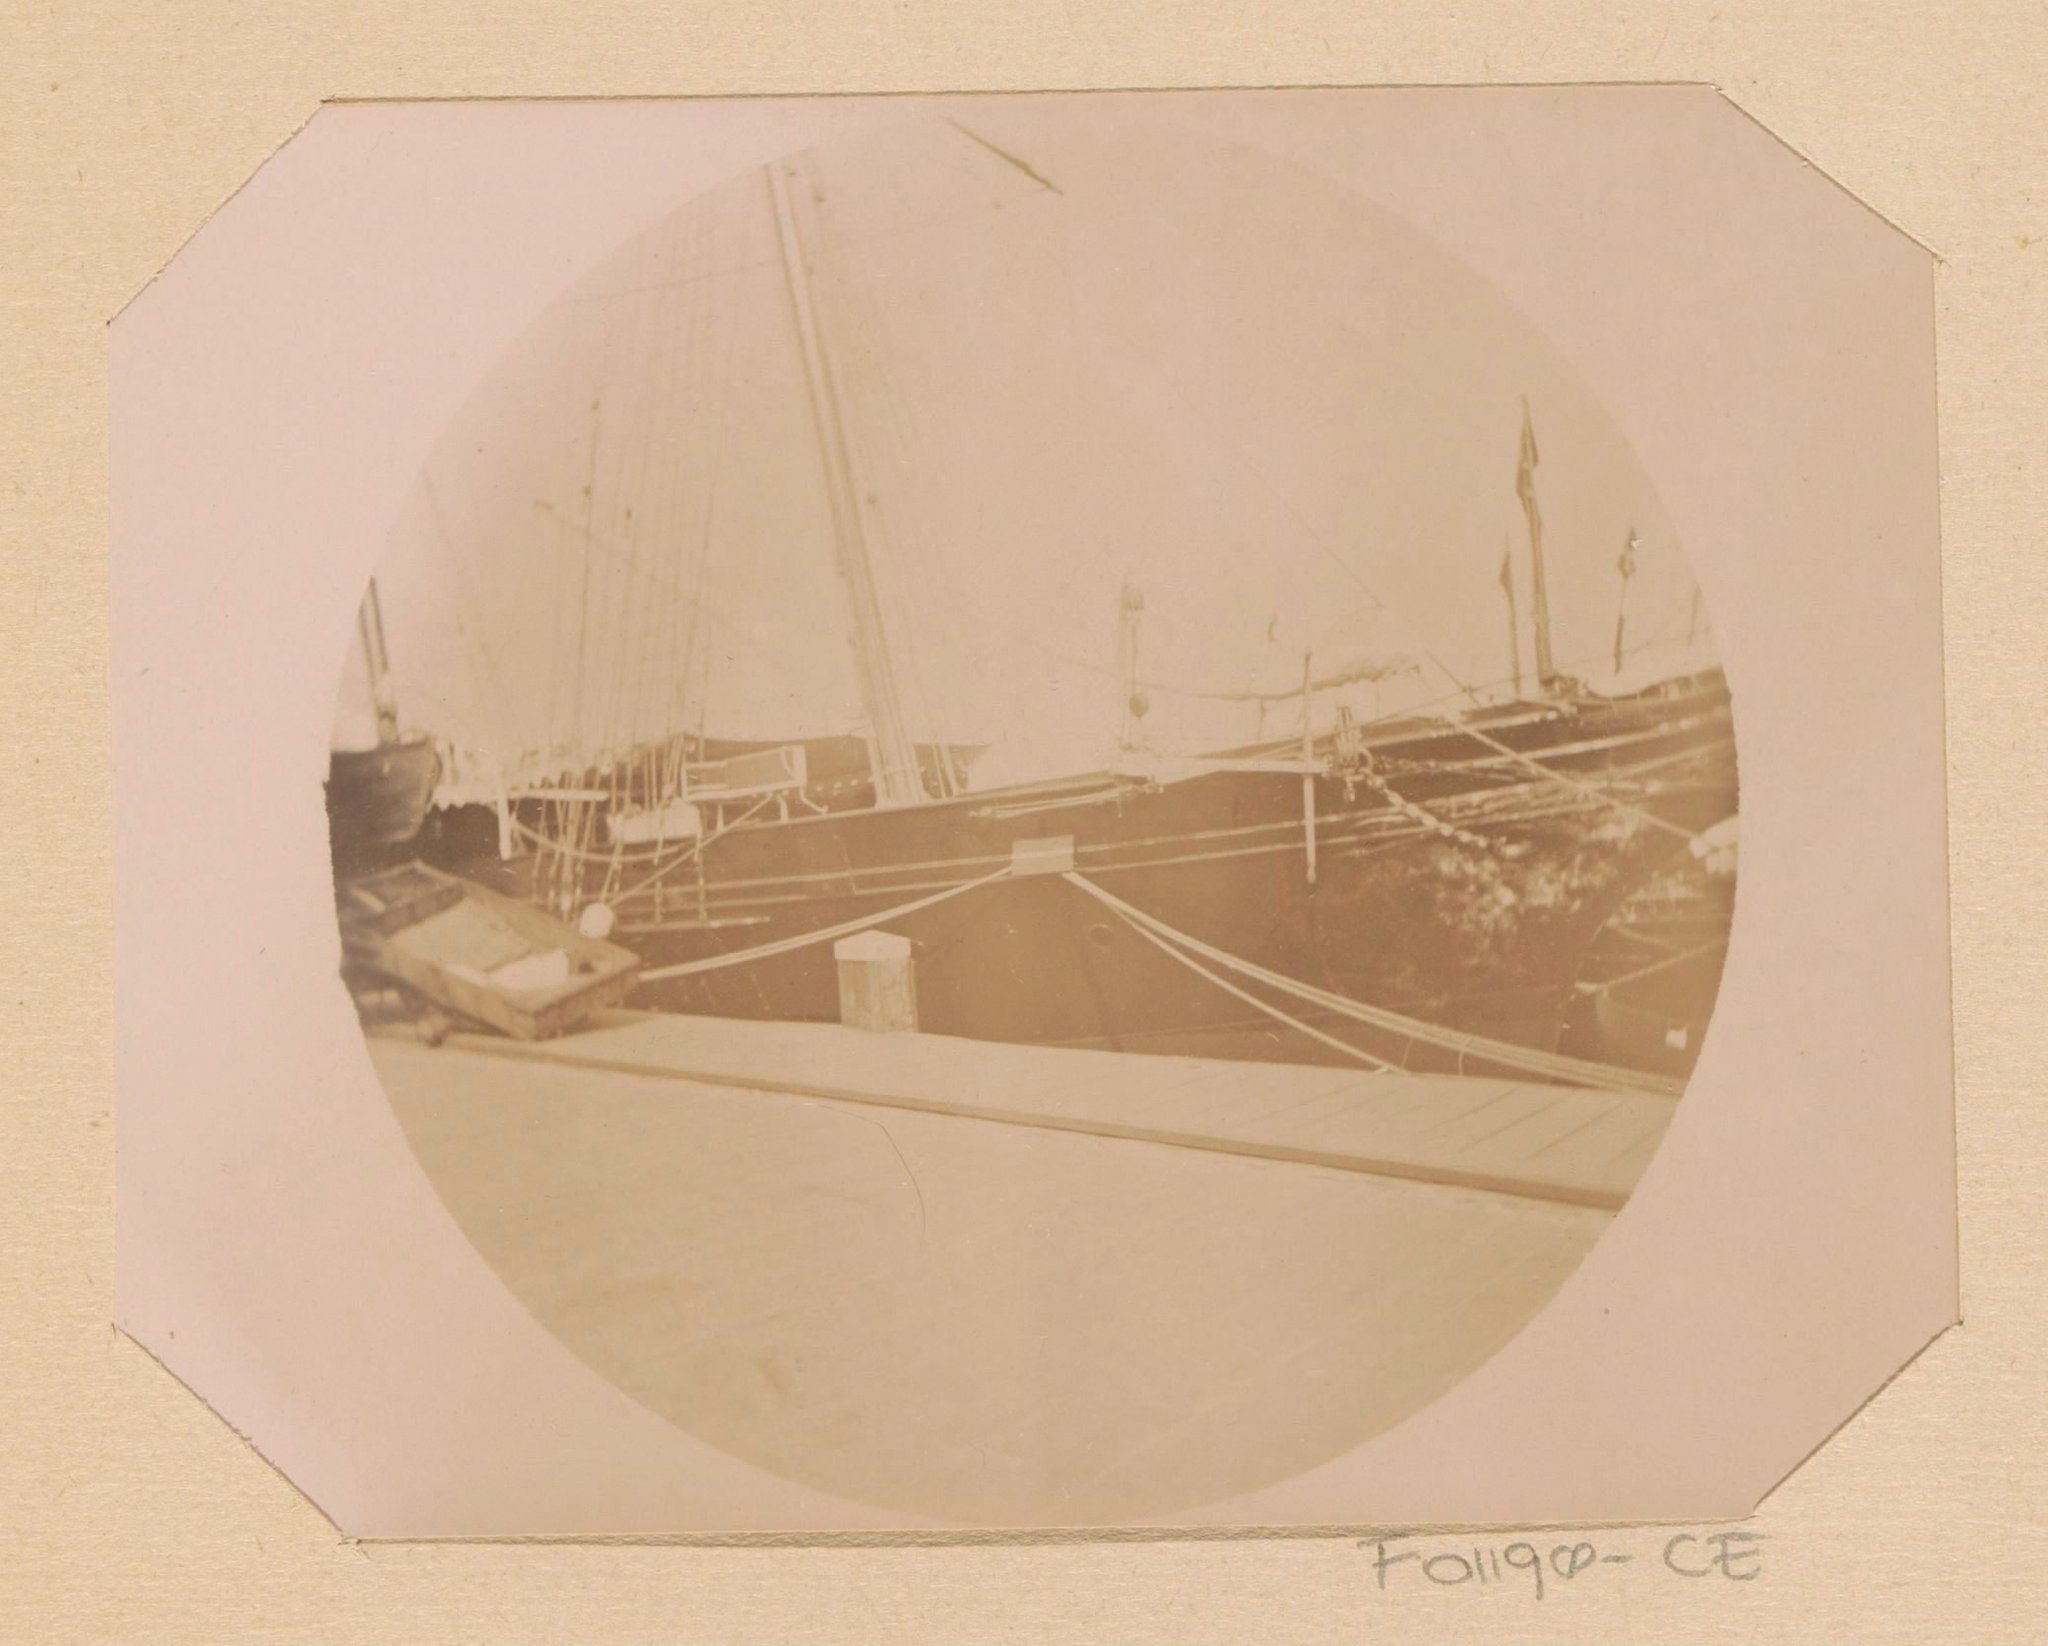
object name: album leaf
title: Aangemeerd schip in het IJ tijdens de Keizersfeesten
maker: johanna margaretha piek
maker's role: fotograaf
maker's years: 1870-1947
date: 1891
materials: paper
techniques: gelatin silver print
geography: amsterdam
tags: ships (in general), amsterdam, imperial celebrations 1891